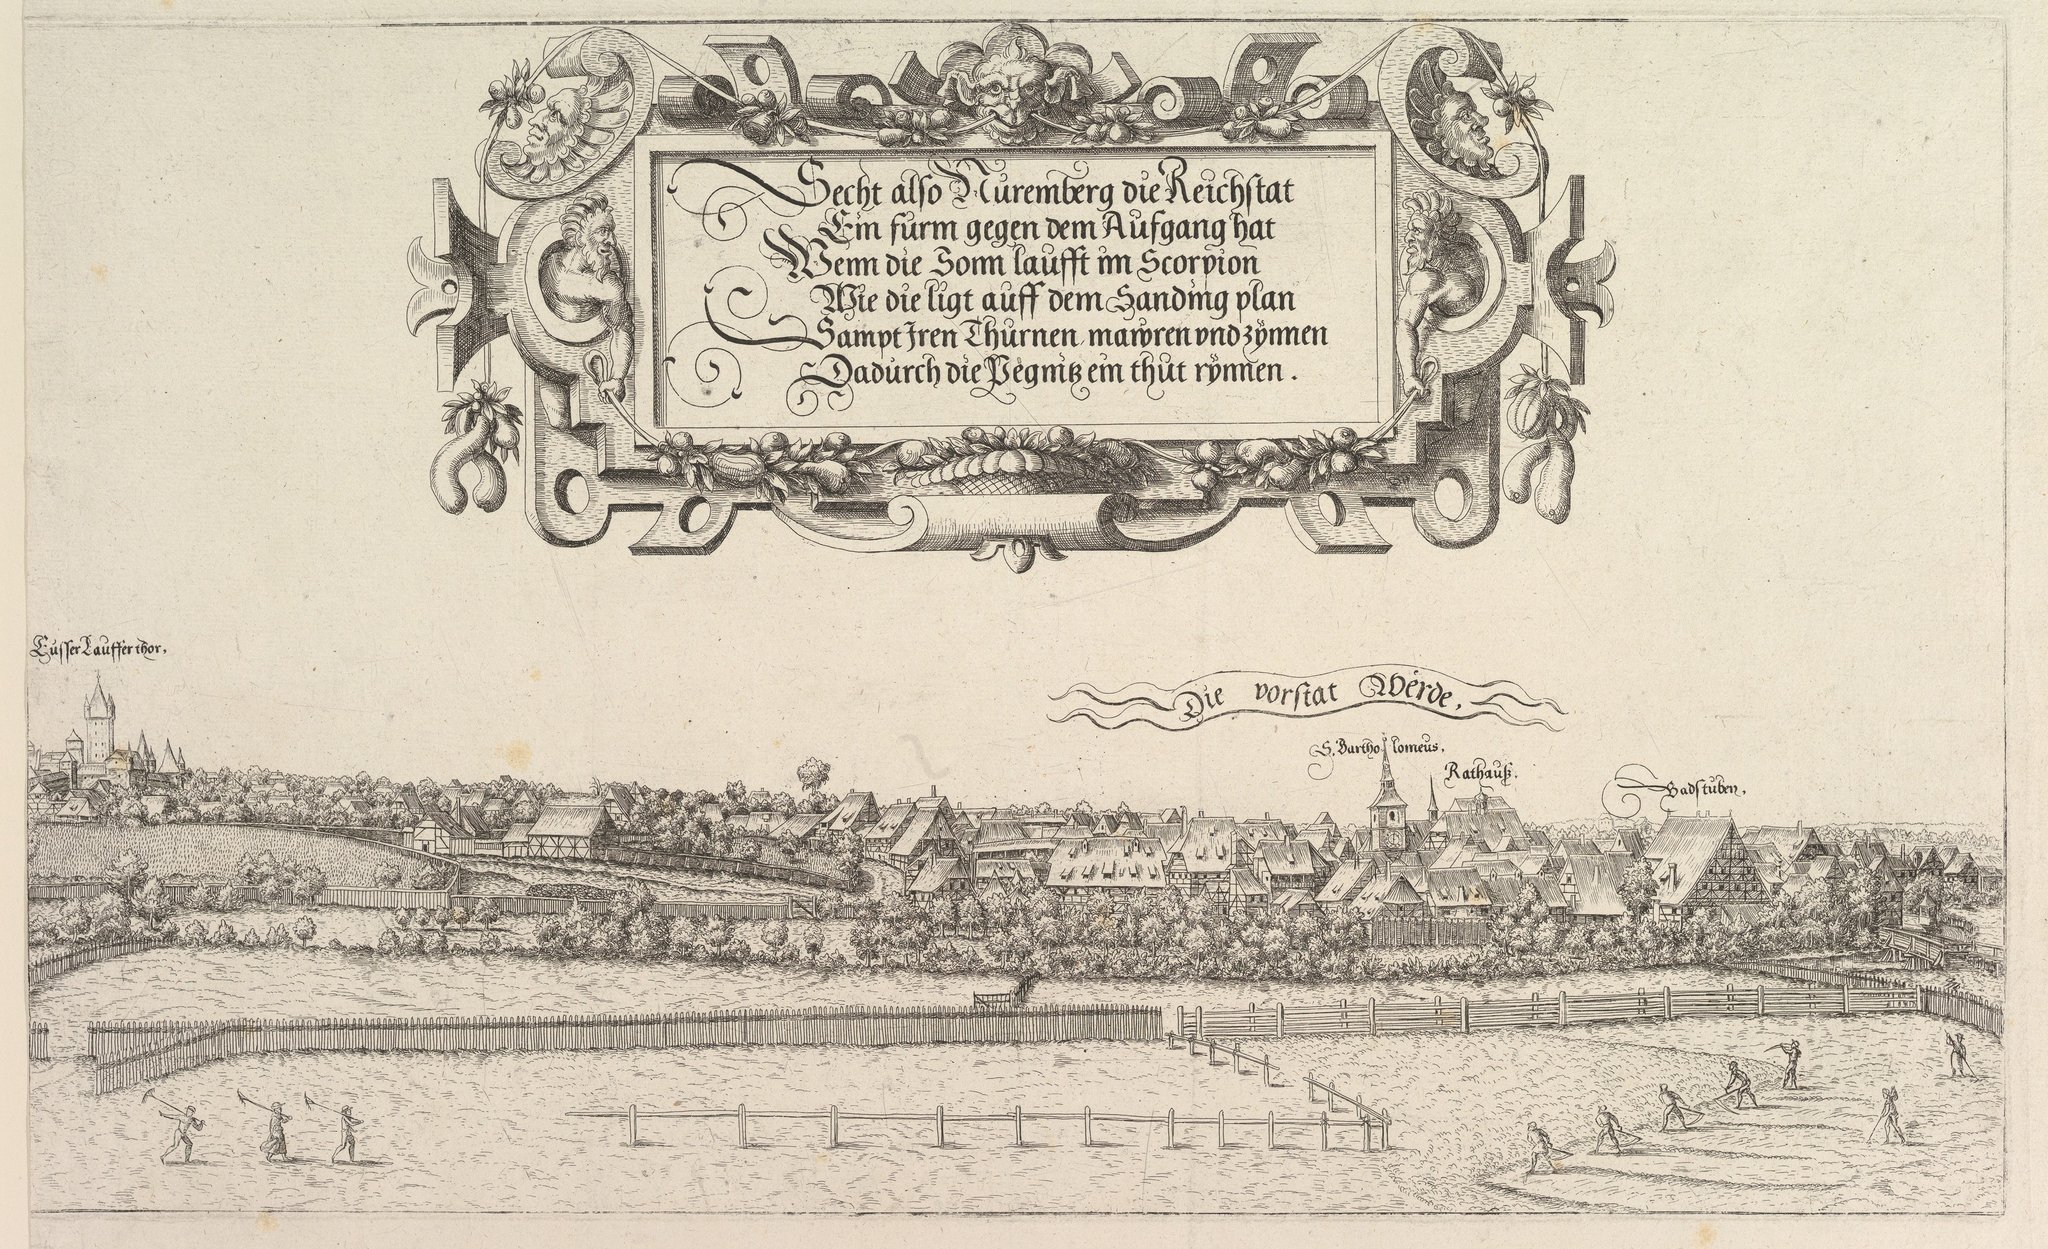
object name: print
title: View of Nuremberg, to the east, right plate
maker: hanns lautensack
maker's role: artist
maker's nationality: german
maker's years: 1515-1566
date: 1552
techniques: etching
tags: buildings